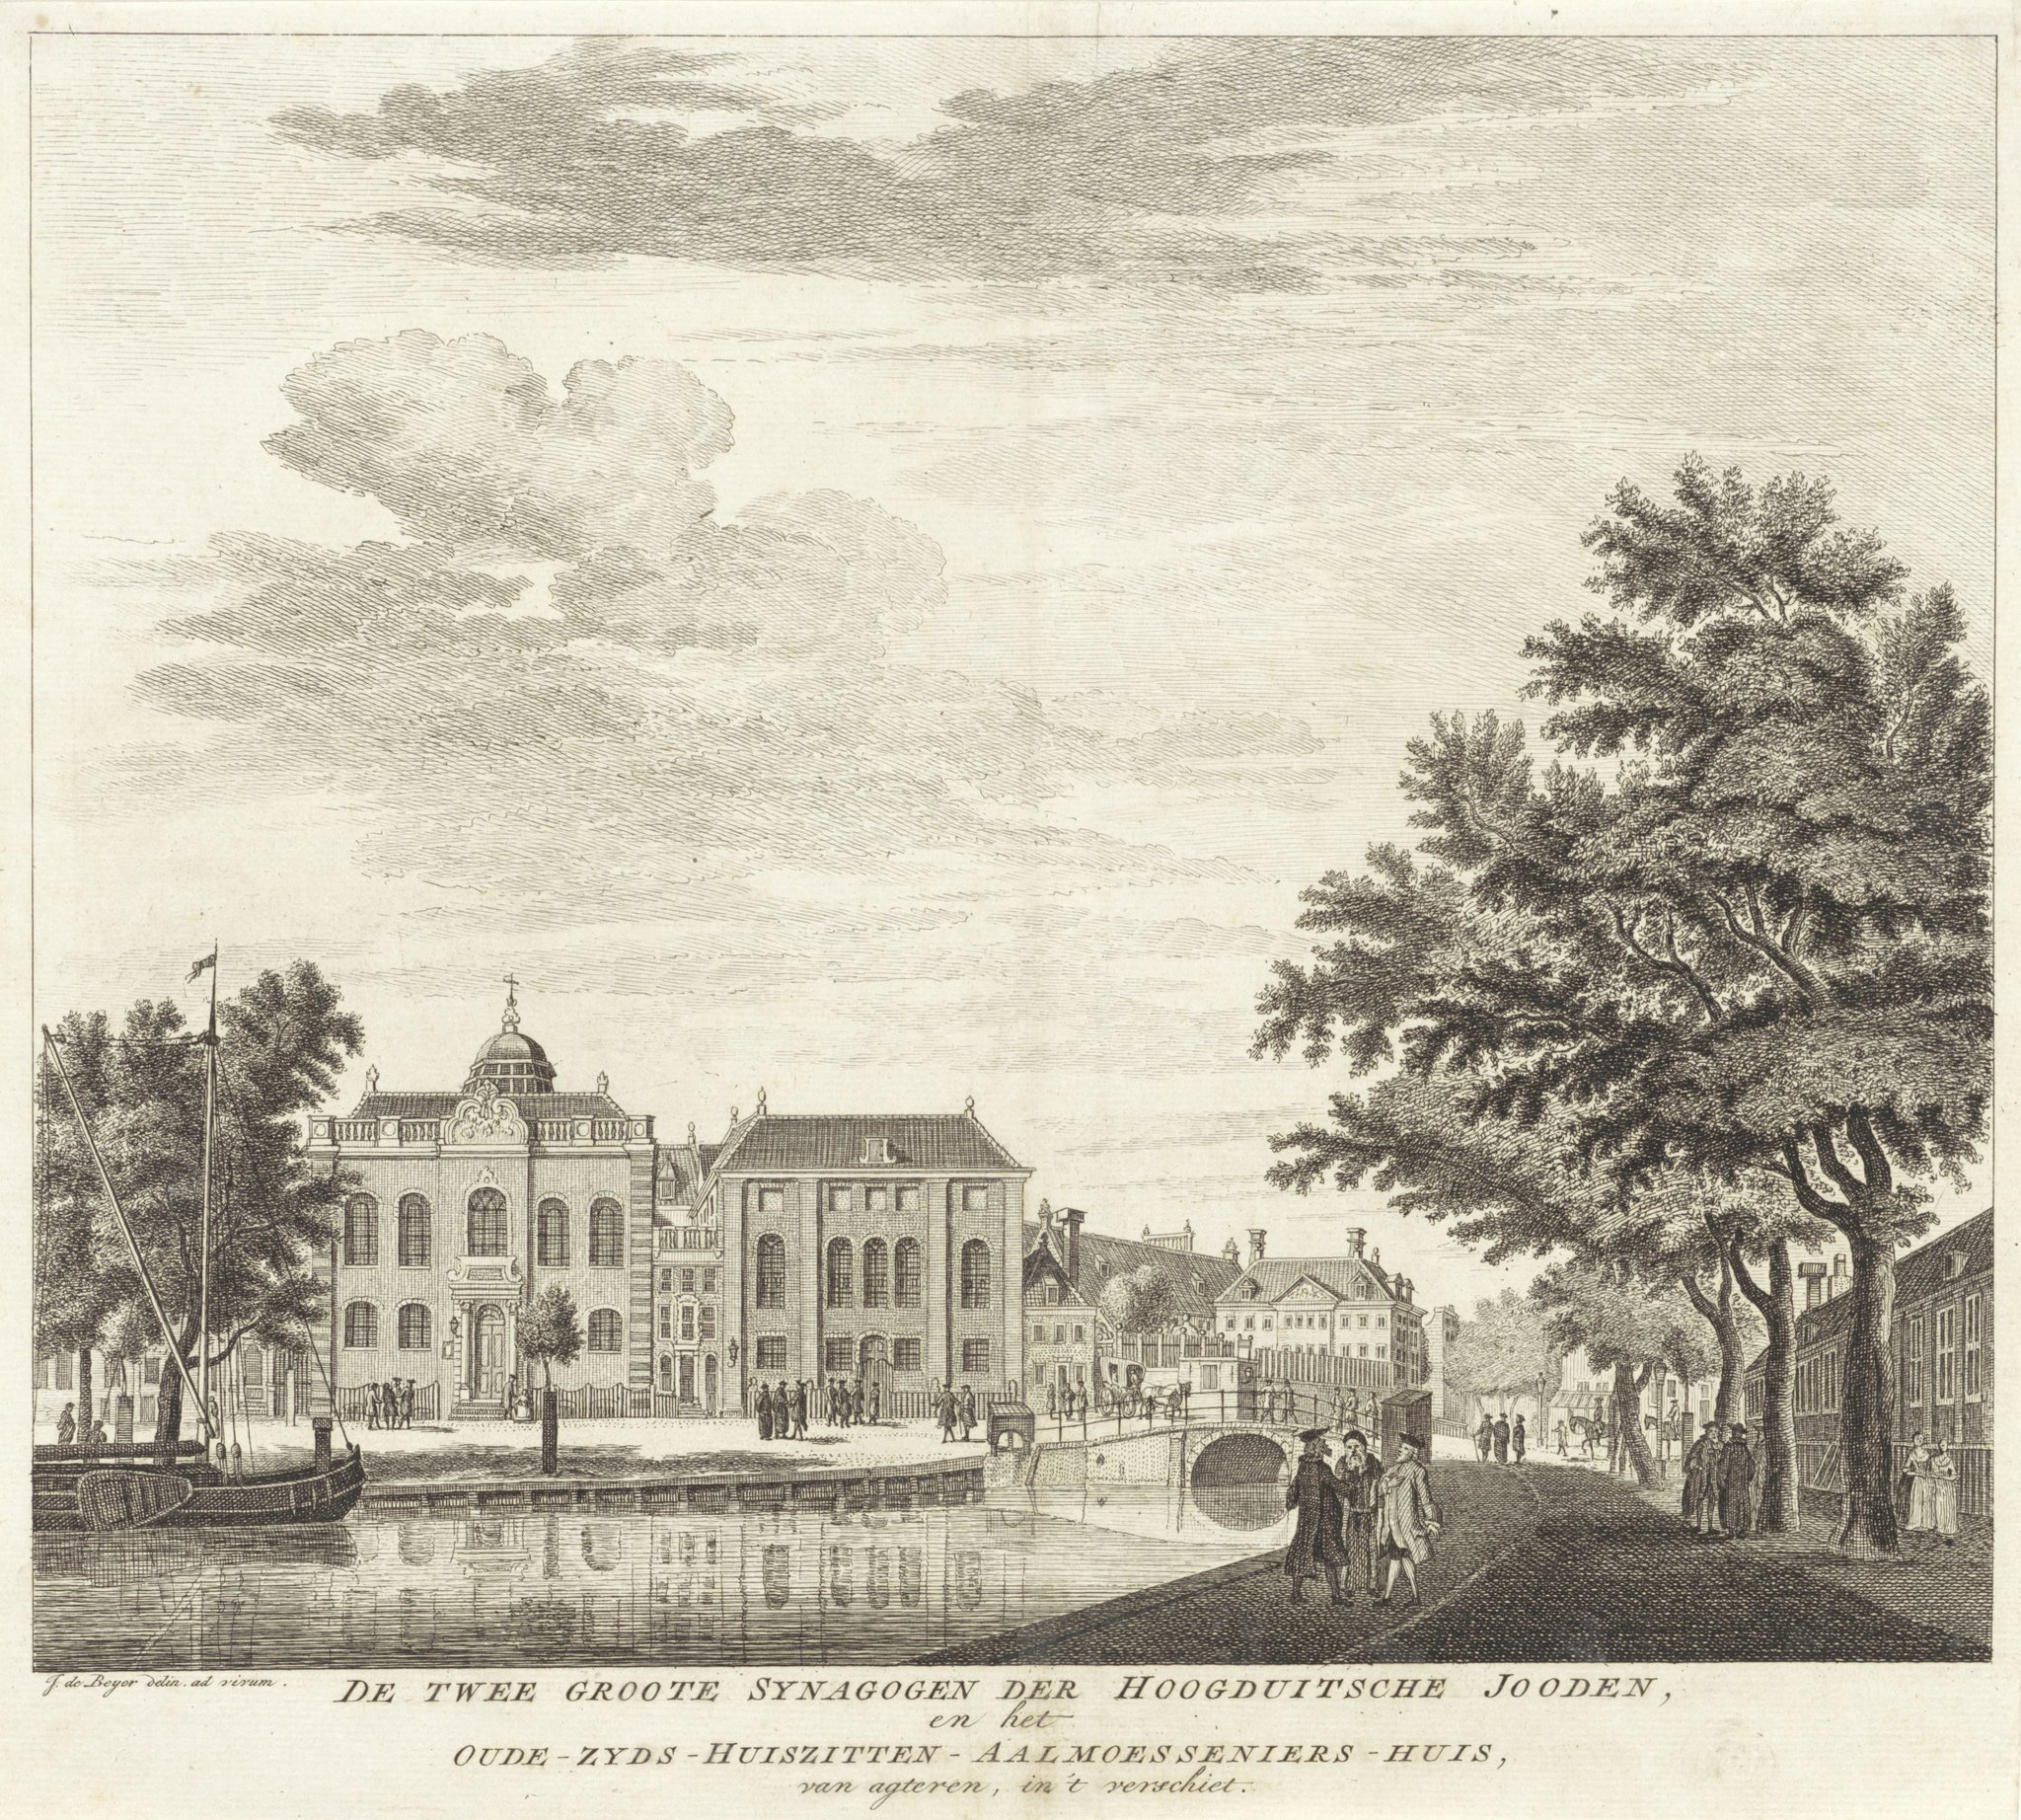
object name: print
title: De twee groote Synagogen der Hoogduitsche Jooden, en het Oude Zyds-Huiszitten-Aalmoesseniers-Huis, van agteren, in 't verschiet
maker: Anonymous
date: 1718-1830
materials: paper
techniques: etching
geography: amsterdam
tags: city-view, and landscape with man-made constructions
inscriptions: collector's mark: Lugt 2228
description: Links liggen de Nieuwe Synagoge en de Grote Synagoge aan het water. In de verte is de achterzijde van de Oudezijds Huiszittenhuis te zien.